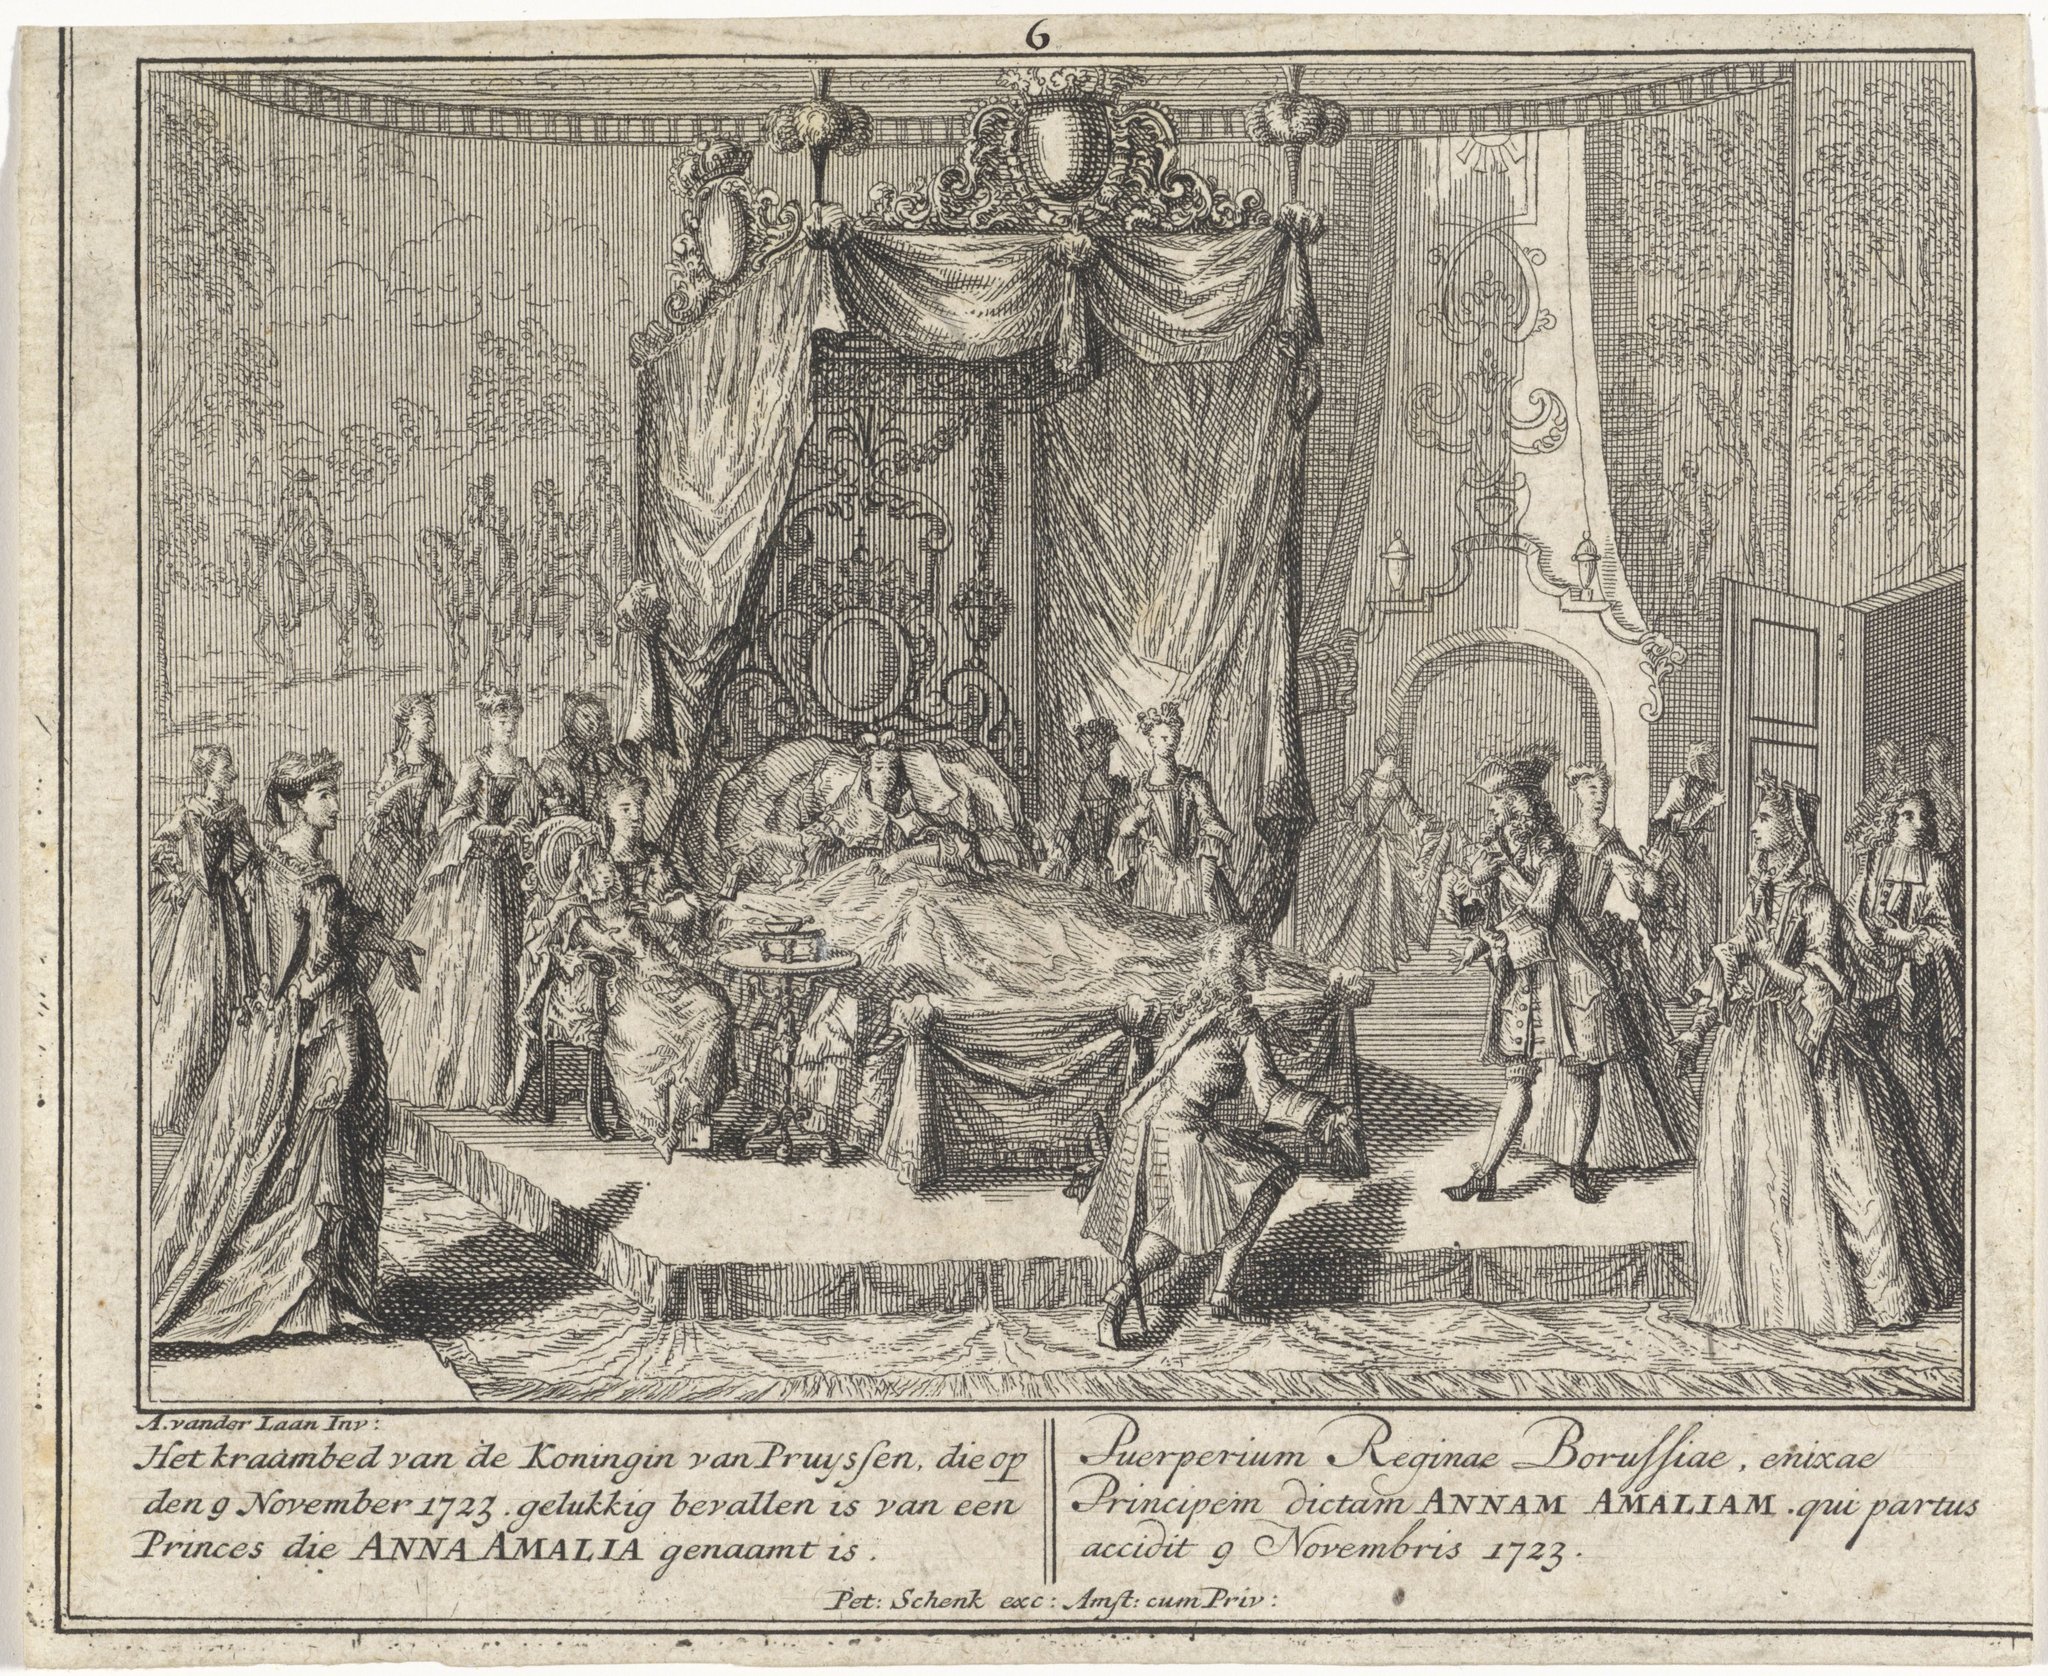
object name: book illustration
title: Het kraambed van de Koningin van Pruyssen, die op den 9 November 1723 gelukkig bevallen is van een Princes die Anna Amalia genaamt is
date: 1727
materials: paper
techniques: etching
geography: amsterdam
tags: visiting the new mother, lying-in visit, bedroom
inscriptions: collector's mark: Lugt 2228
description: Sophia Dorothea van Hannover, koningin-gemalin van Pruisen, ligt in het kraambed na de geboorte van Anna Amalia. Links zit een hofdame met de kleine prinses op haar schoot. Verschillende hovelingen kijken toe. Linksonder een drieregelige tekst in het Nederlands met een toelichting op de voorstelling en rechts dezelfde toelichting in het Latijn.